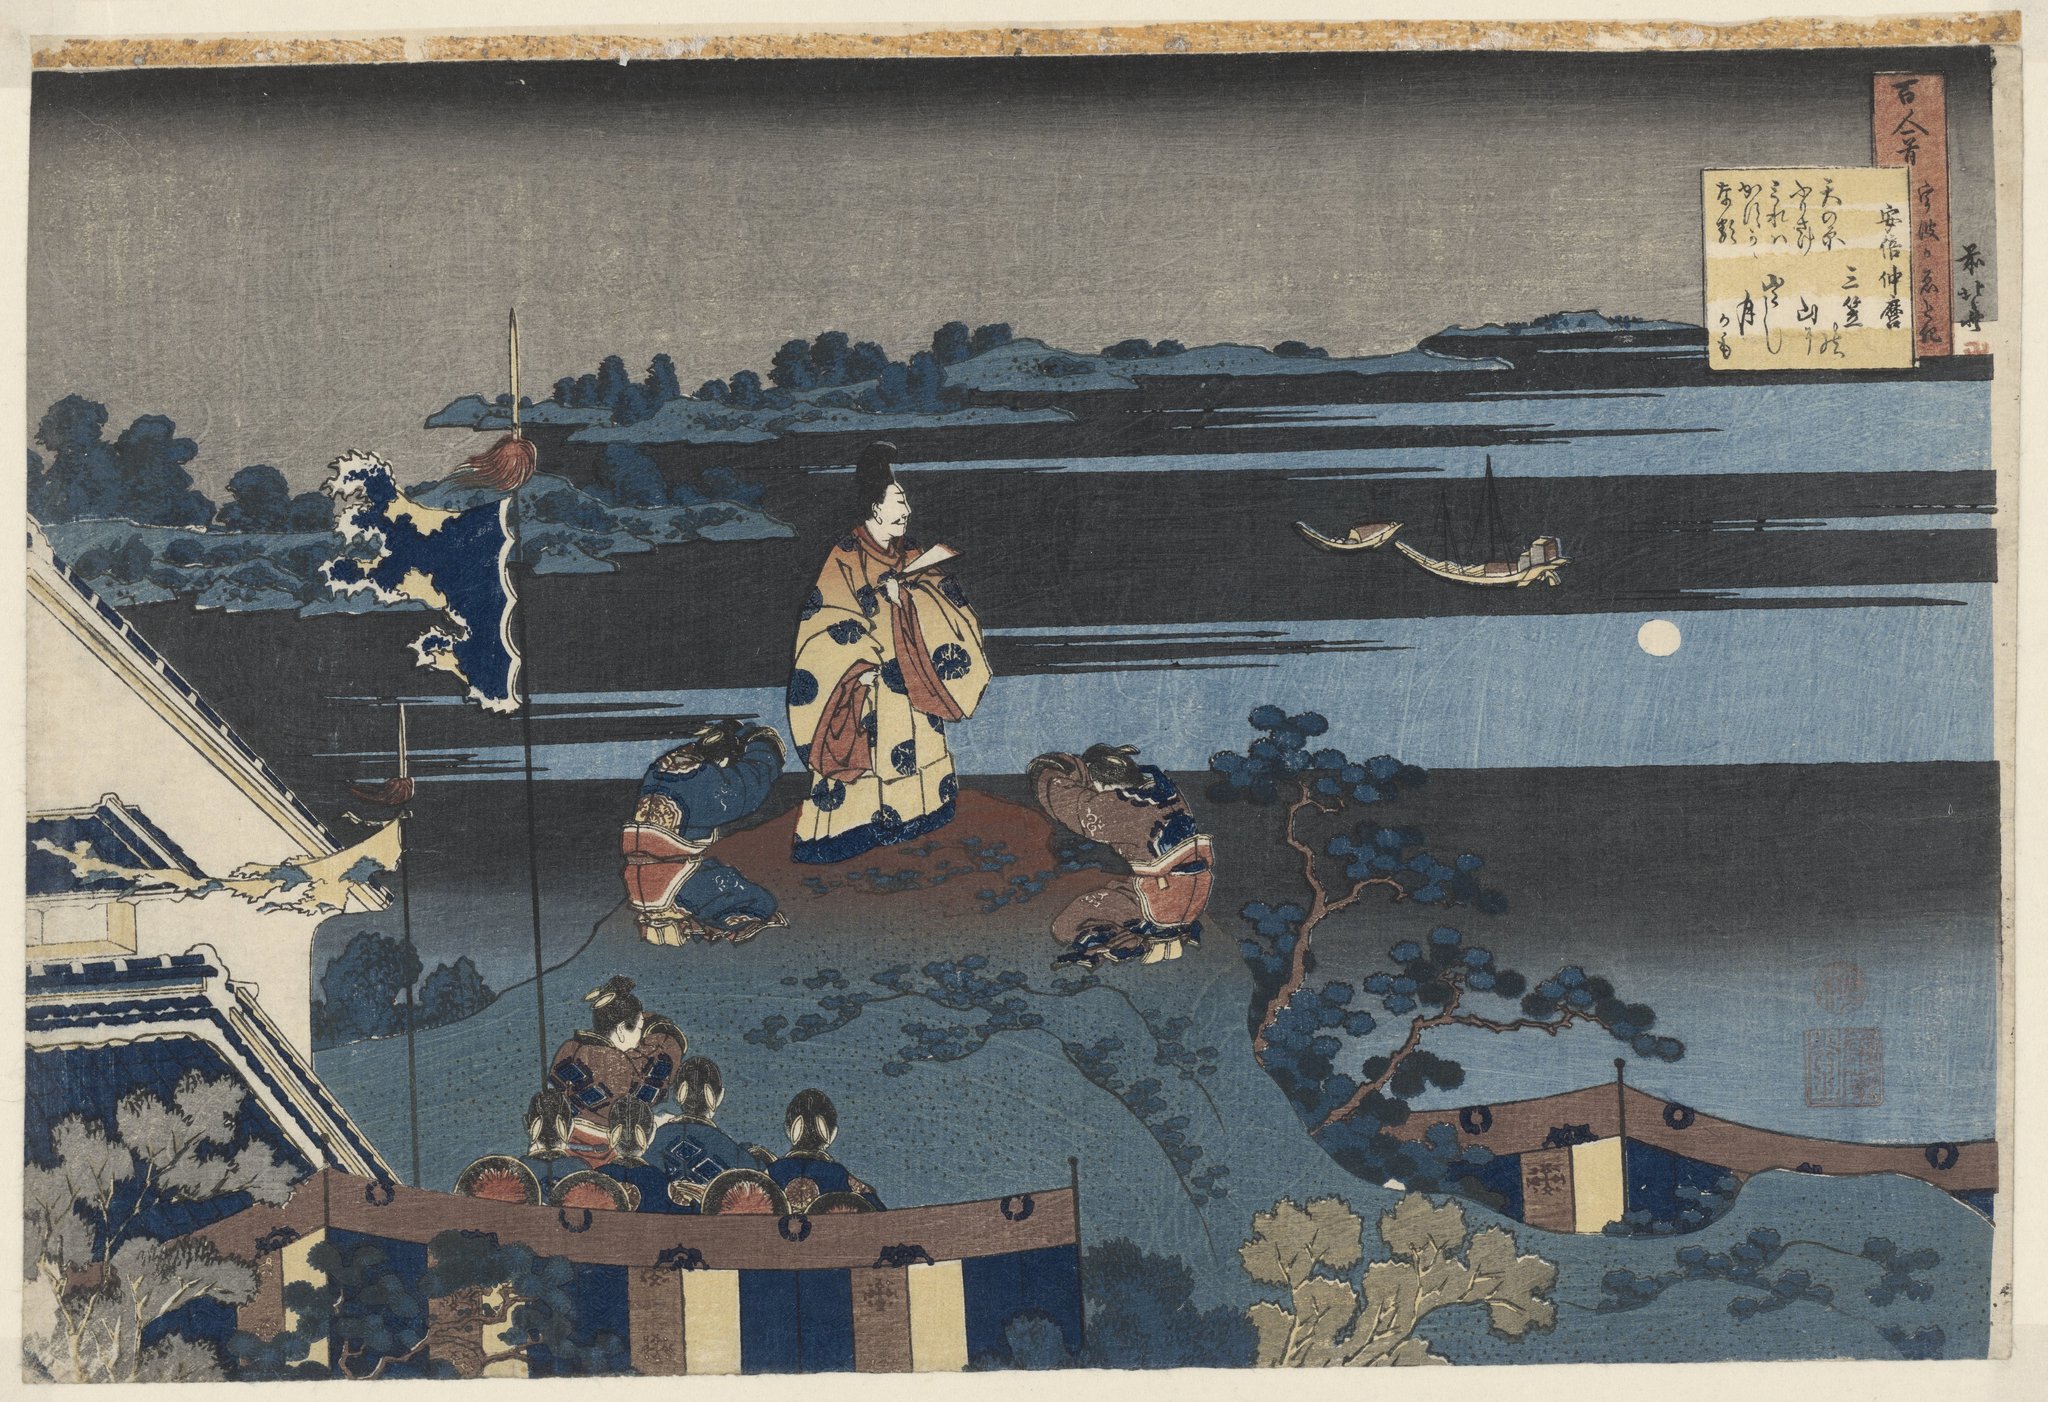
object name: print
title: Gedichten door elk van de 100 dichters, uitgelegd door de voedster.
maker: katsushika hokusai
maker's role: draughtsman, print maker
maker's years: 1760-1849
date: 1833-1837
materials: paper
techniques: woodcut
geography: japan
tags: writer, poet, author, mountains, sea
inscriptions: collector's mark: Lugt 2228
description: De dichter Abe no Nakamaro op een bergtop in China uitkijkend over de zee, waarin de weerspiegeling van de maan. Naast de dichter en op de voorgrond verschillende volgelingen. Gedicht in vierkant cartouche rechtsboven.